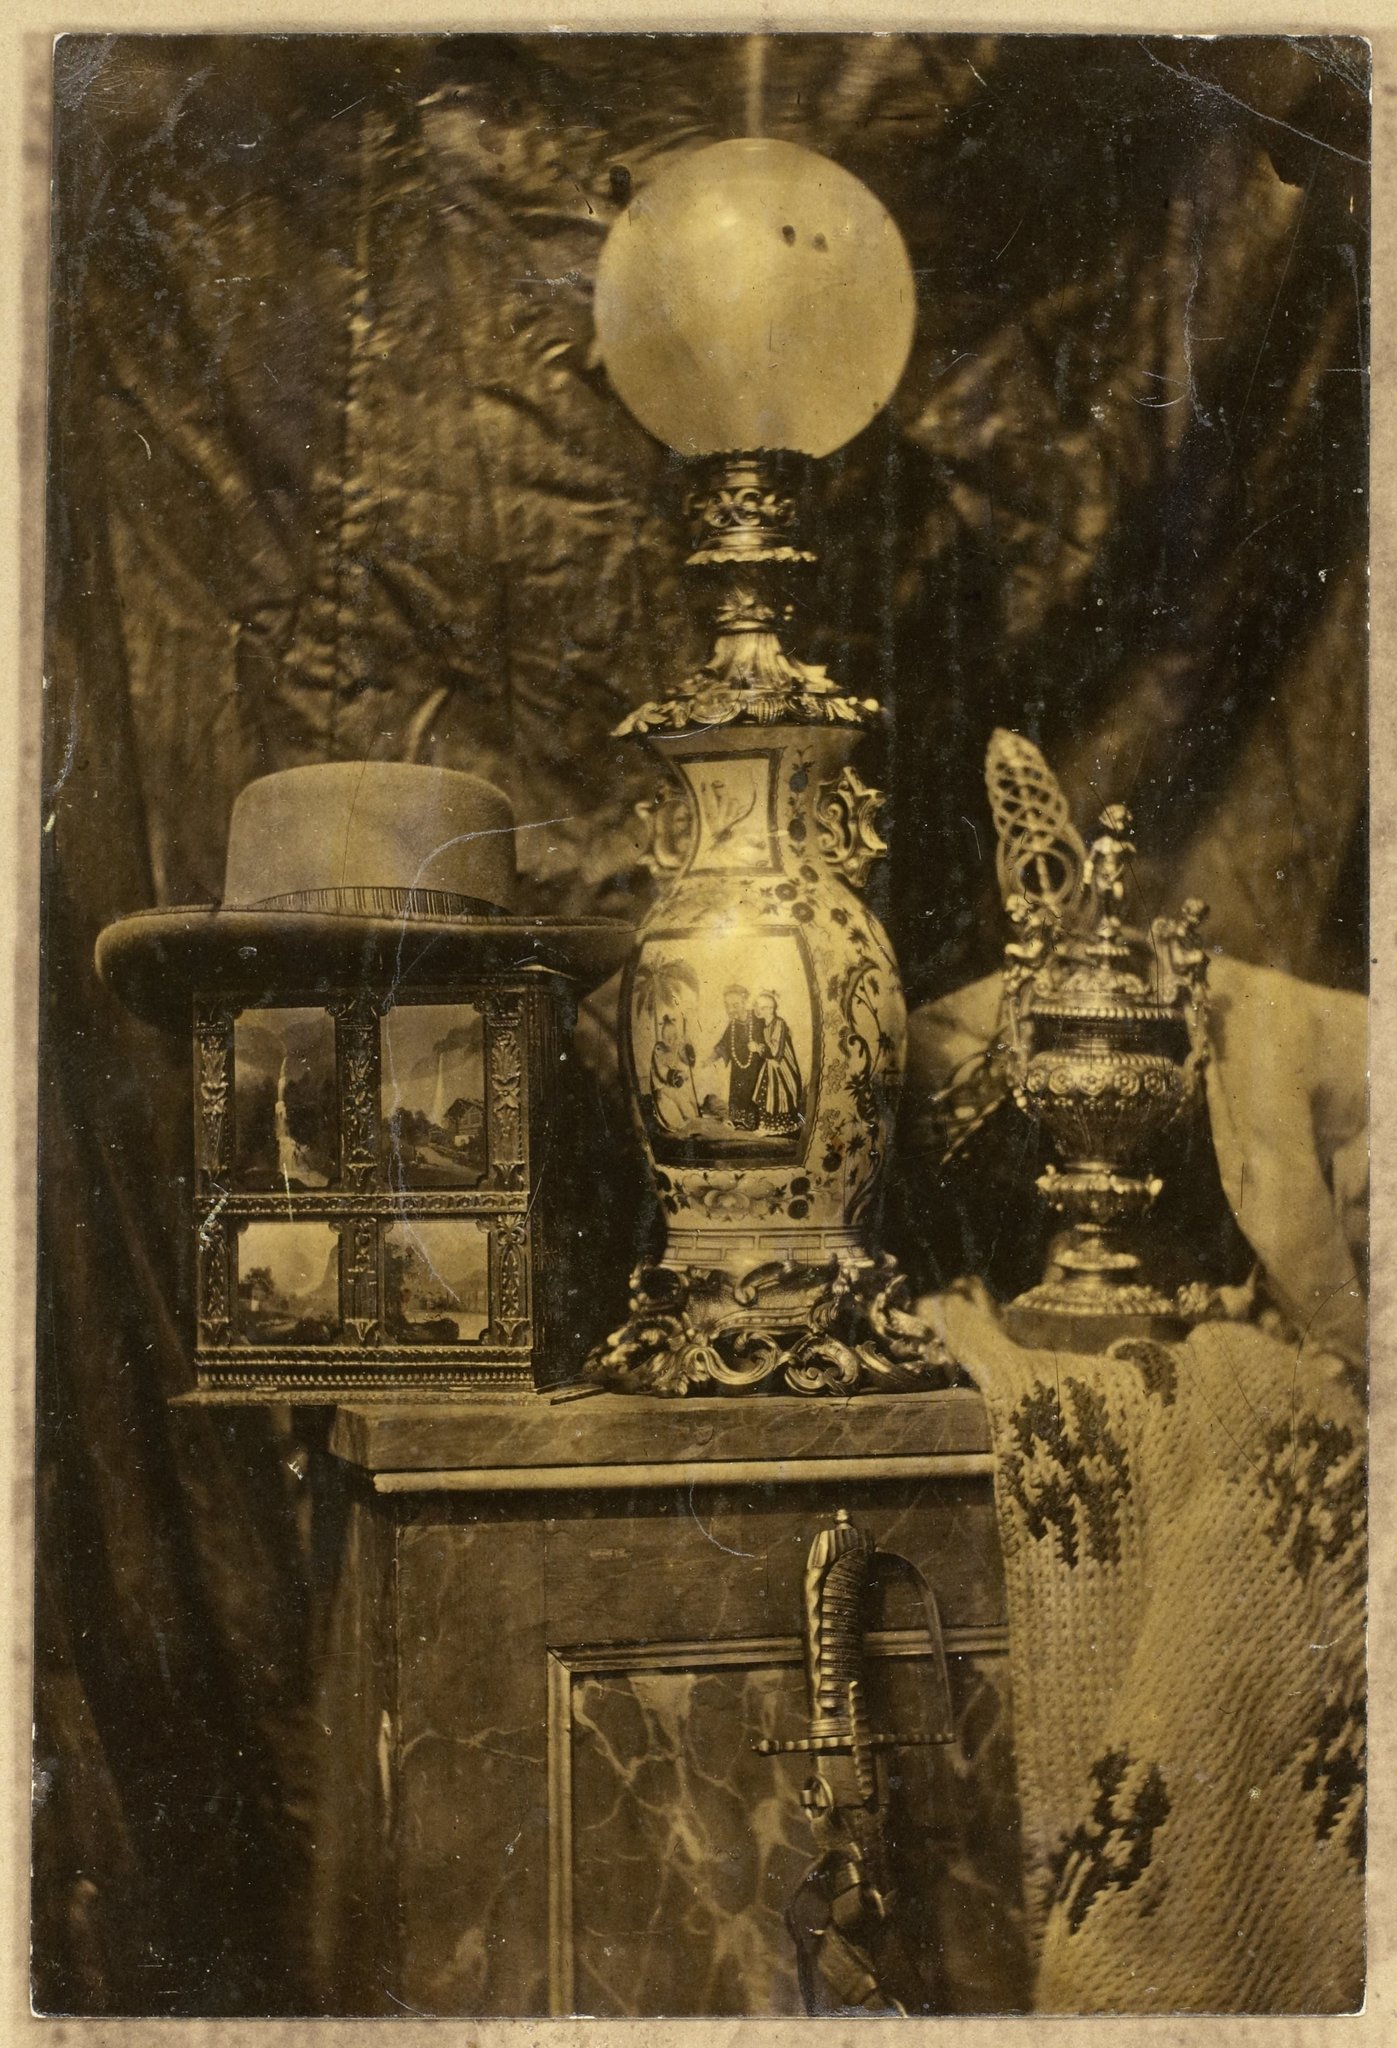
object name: photograph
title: Stilleven met stereoscoop, hoed, Chinese vaas, zilveren pronkbokaal en degen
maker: eduard isaac asser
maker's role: amateurfotograaf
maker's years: 1809-1894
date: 1855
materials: cardboard, paper, photographic support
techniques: salted paper print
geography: amsterdam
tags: still life of miscellaneous objects